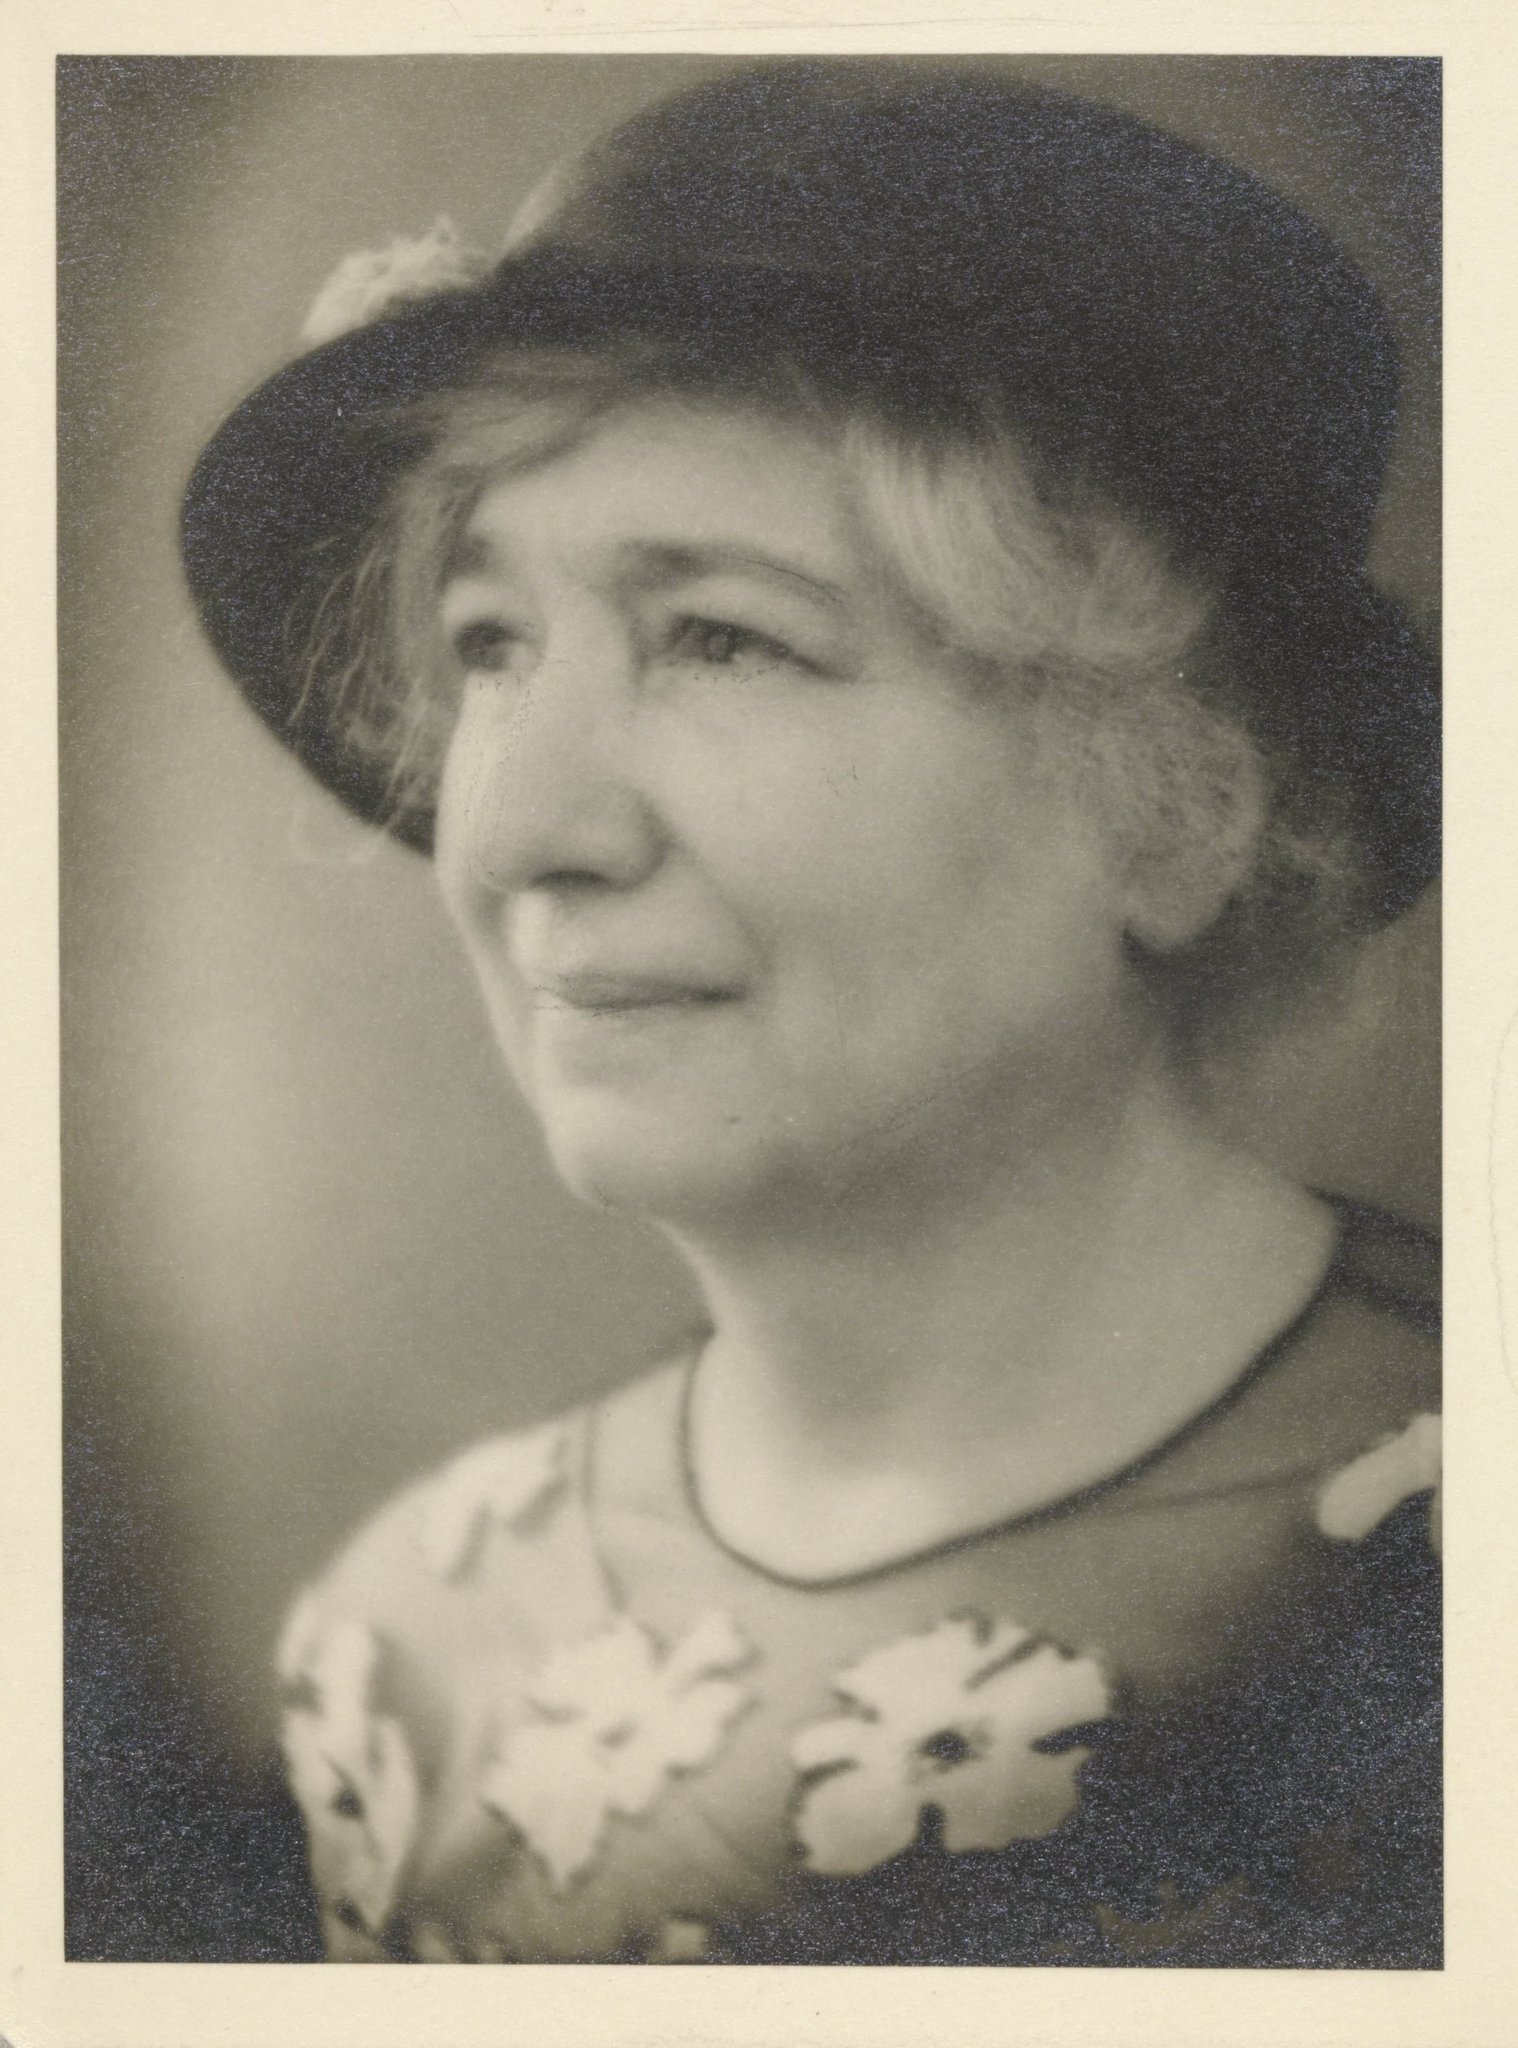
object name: photograph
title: Marie Witsen-Schorr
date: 1860-1915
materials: paper, photographic support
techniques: gelatin silver print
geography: netherlands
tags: amsterdam, augusta maria agnes witsen-schorr